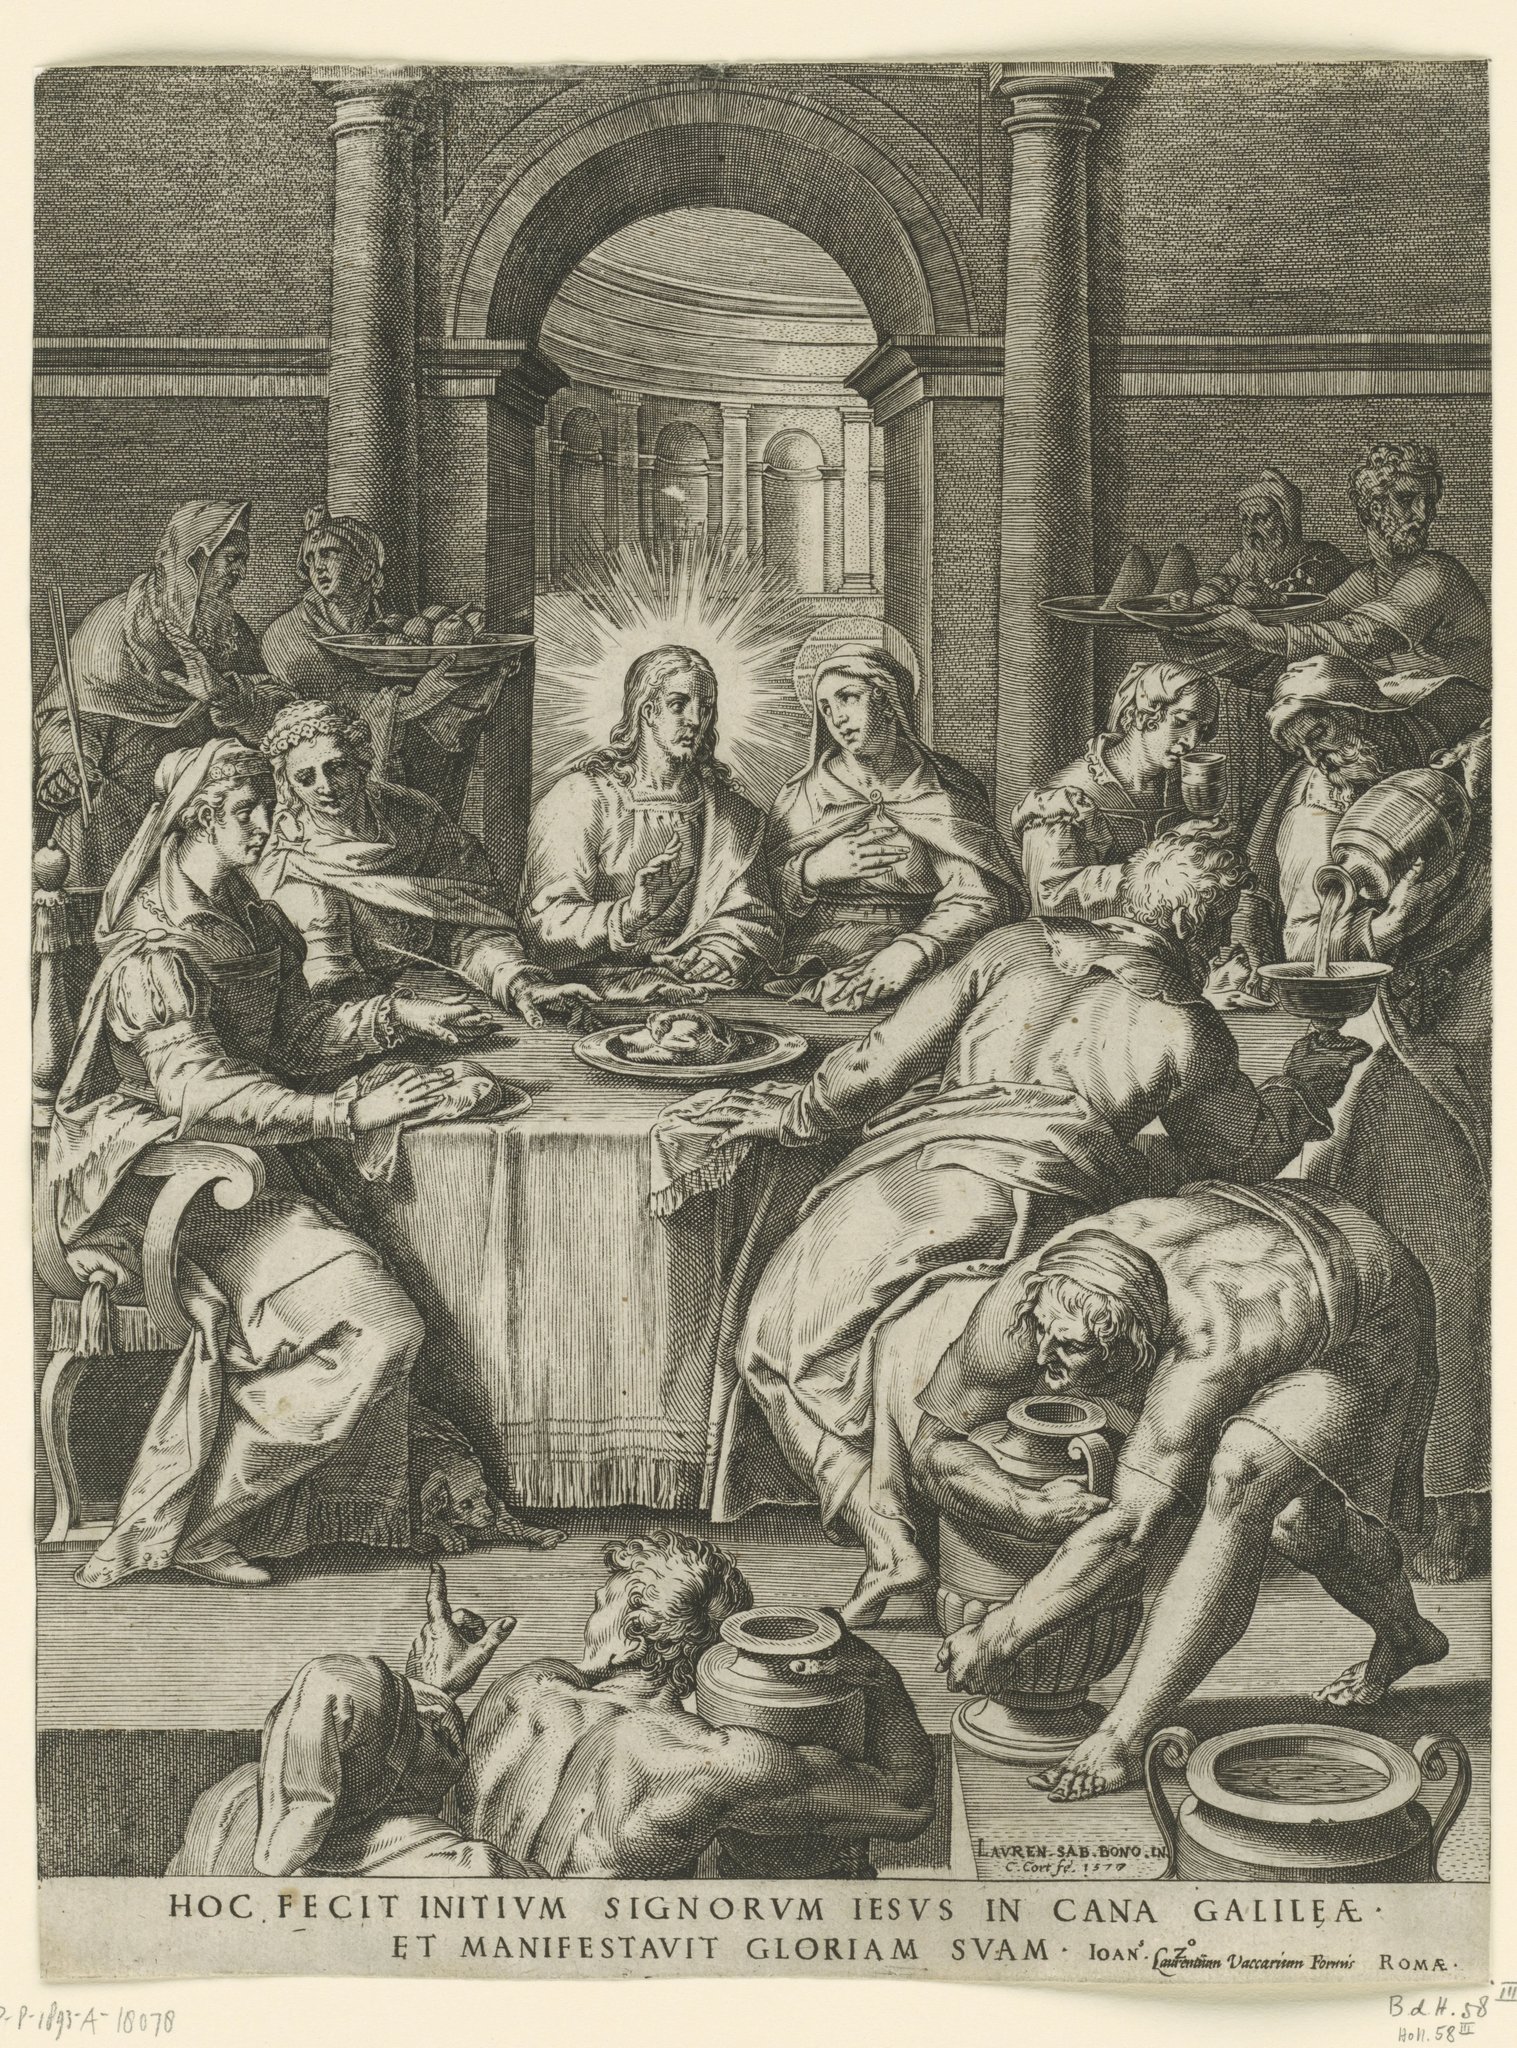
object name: print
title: Bruiloft te Kana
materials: paper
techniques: engraving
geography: rome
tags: the marriage-feast at cana (john 2:1-11), the wine is tested ~ marriage-feast at cana, wine-steward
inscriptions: caption: ‘HOC FECIT INITIUM SIGNORUM IESUS IN CANA GALILEAE / ET MANIFESTAVIT GLORIAM SUAM. Ioan. 2.’, signature: ‘1577’, address: ‘Laurentium Vaccarium Formis’, signature: ‘Lauren Sab(atini) Bono in.’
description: Christus zit met Maria naast zich aan een tafel. Links zitten twee vrouwen, rechts een vrouw die uit een beker drinkt. Op de voorgrond worden kruiken wijn uit de kelder aangedragen. Rechts zit een man op de rug gezien die de wijn keurt. Door een boogvormige opening met zuilen gezicht in een tweede ruimte.